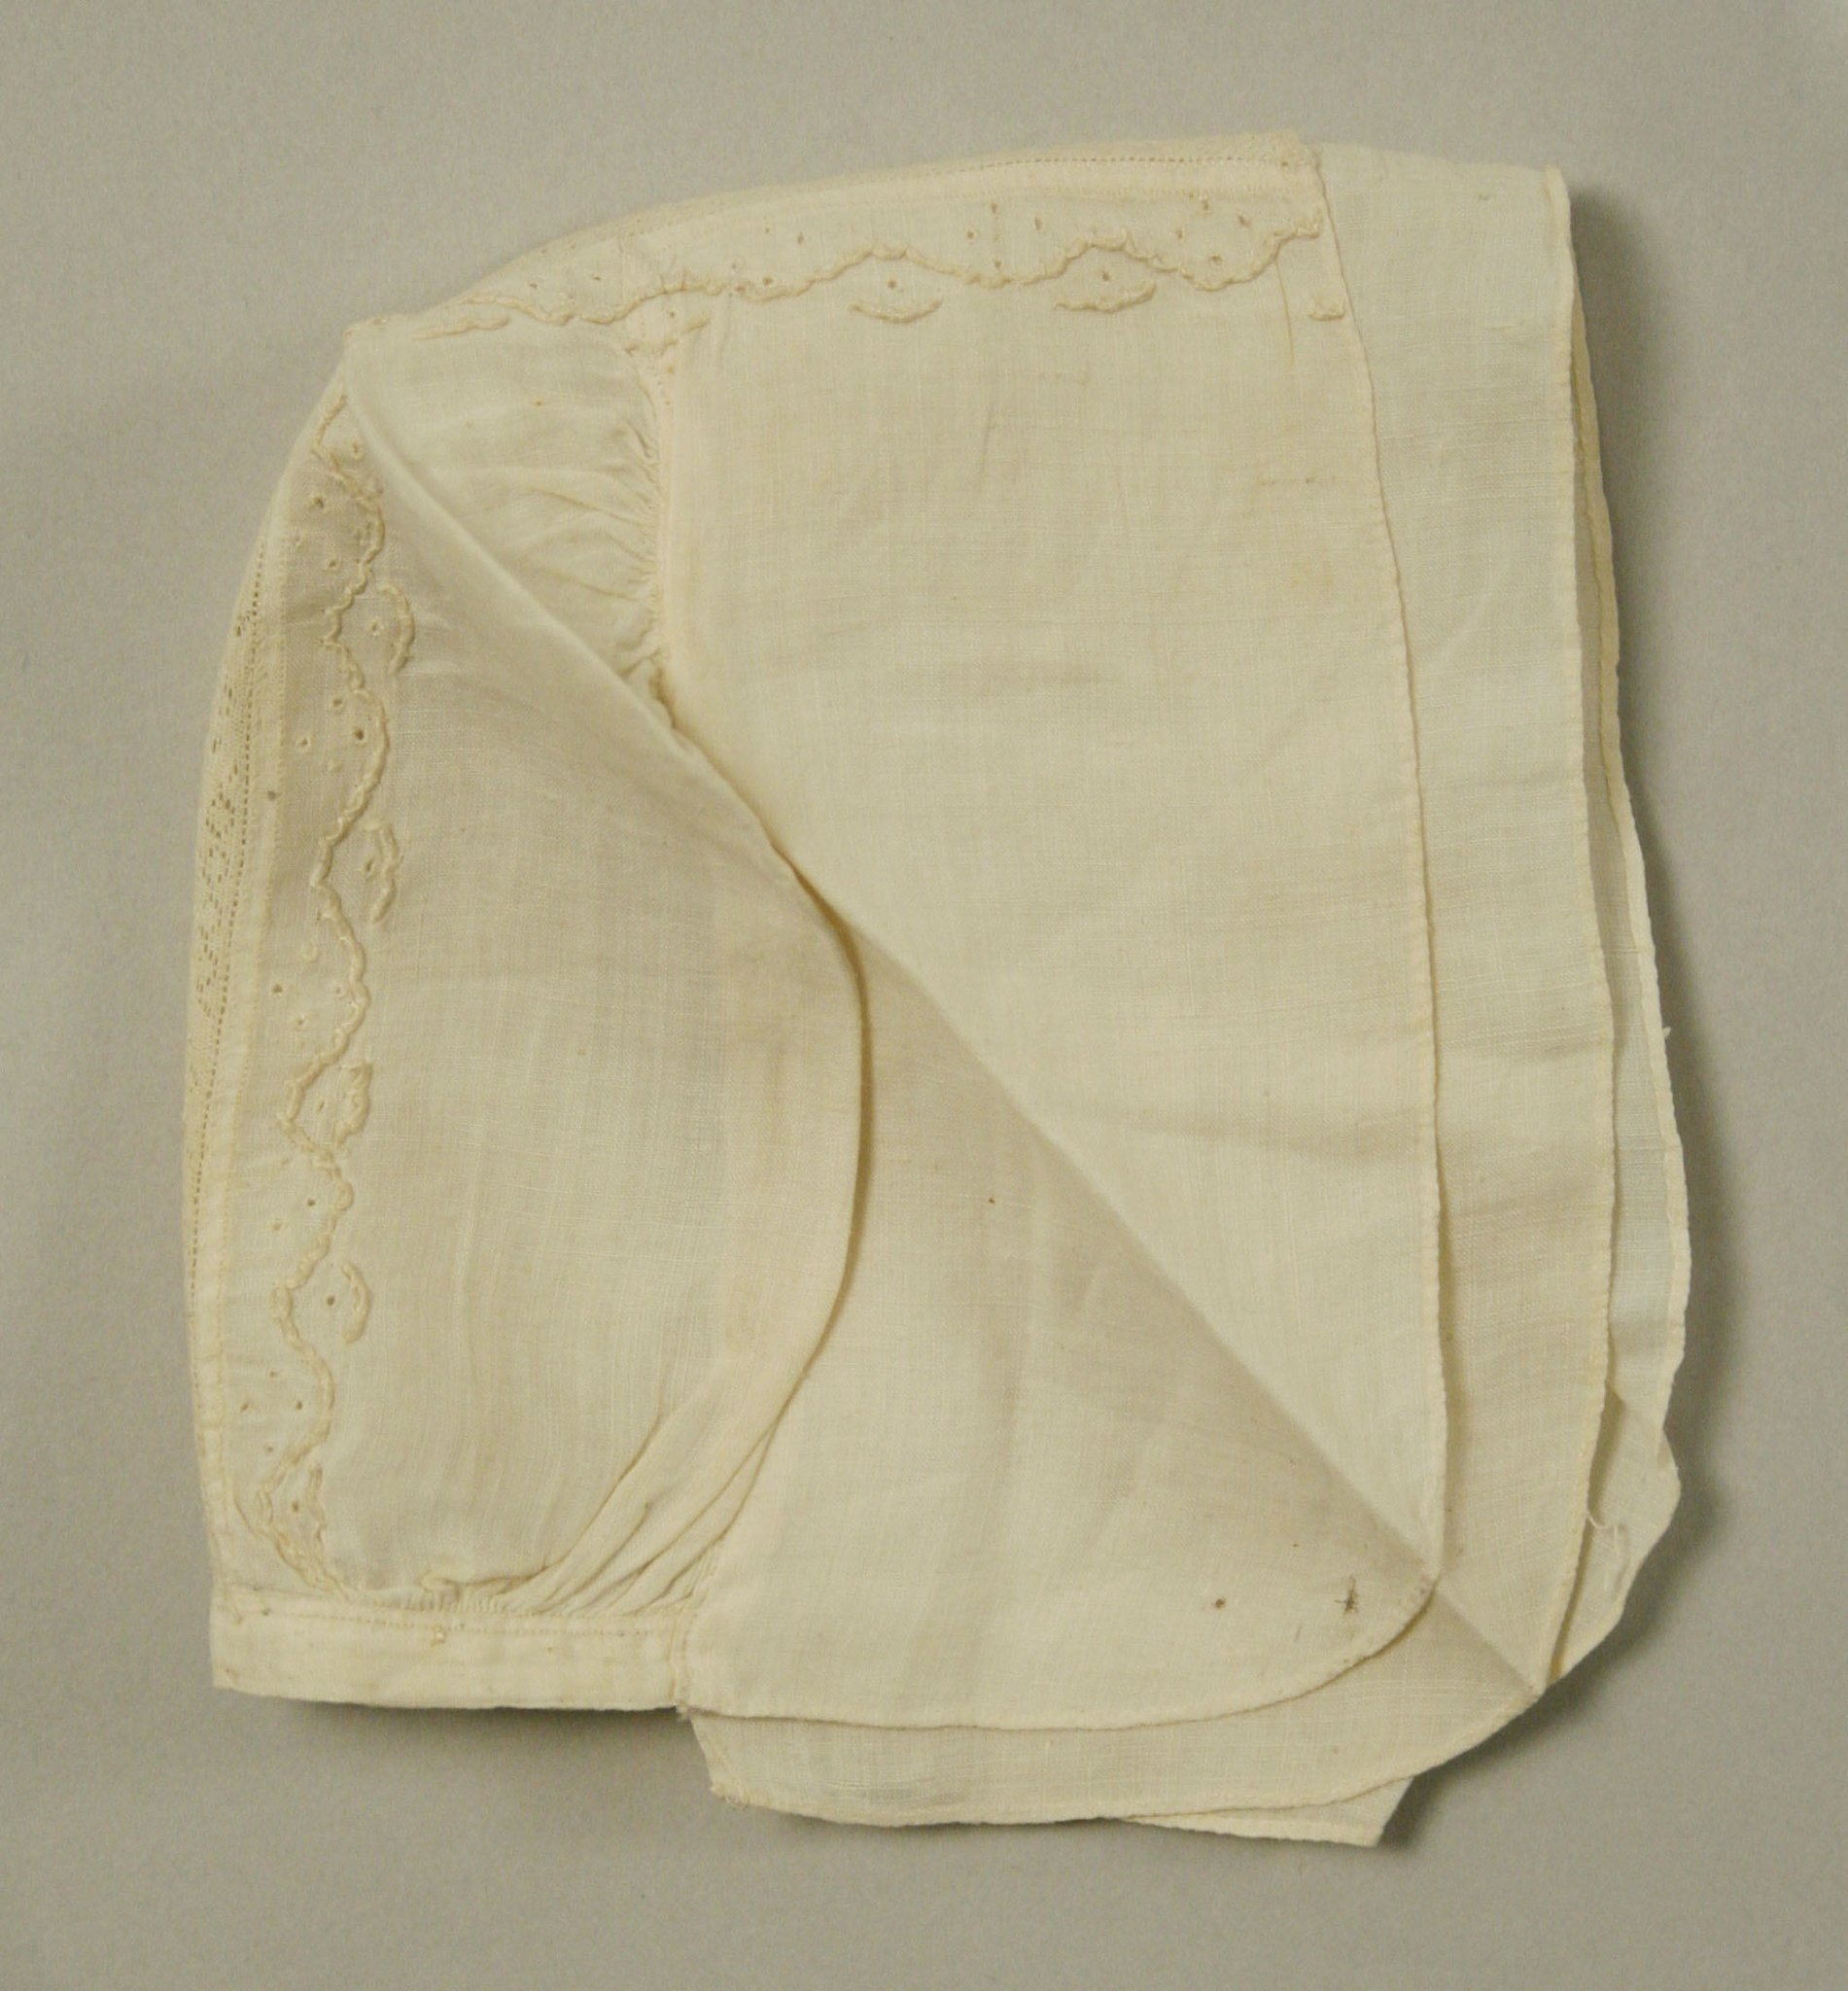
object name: biggin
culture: british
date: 1701-1800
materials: linen